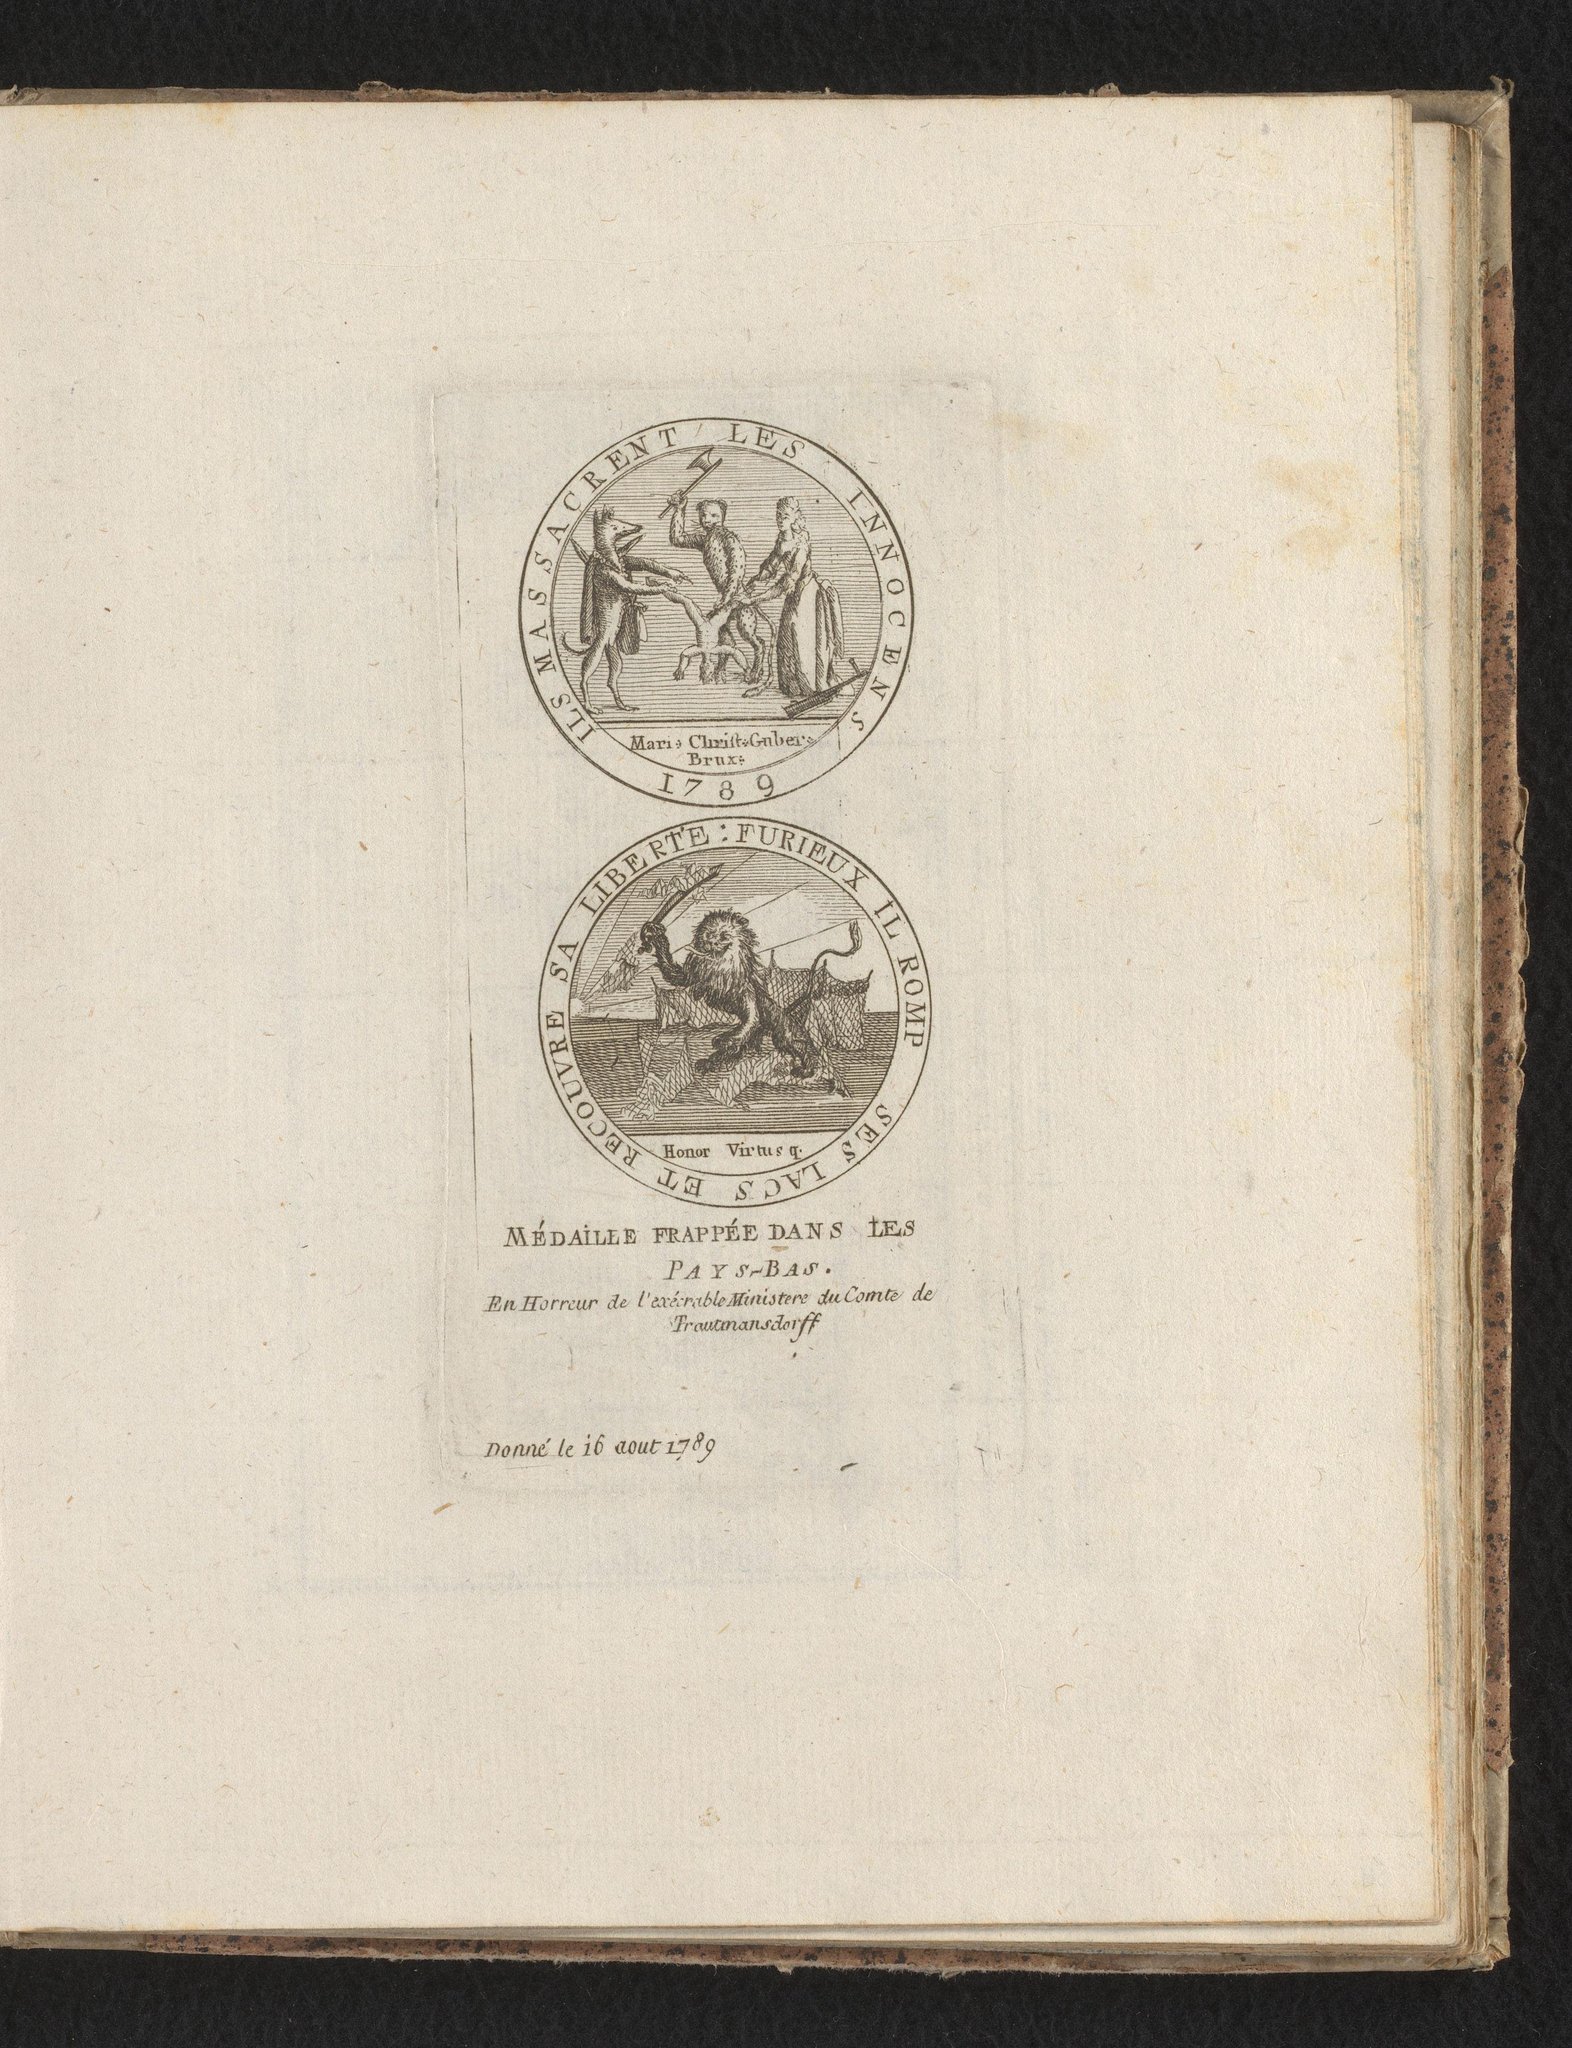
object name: print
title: Médaille frappée dans les Pays-Bas. En Horreur de l'exécrable Ministre du Comte de Strautmansdorf (Trautmansdorff)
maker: Anonymous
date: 1787-1790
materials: paper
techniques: engraving, etching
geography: southern netherlands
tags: vienna, medal (considered as a piece of sculpture, regardless of its specific function), brabant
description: Beide zijden van een penning tegen de wreedheden bedreven in Brabant; met de datum 16 augustus 1789. Op de voorzijde houden een wolf en een vrouw een kind vast dat doormidden wordt gehakt door een luipaard. Op de keerzijde bevrijdt de Brabantse leeuw zich uit een net. In het onderschrift wordt er verwezen naar landvoogd Trauttmansdorff. Onderdeel van de gebundelde verzameling prenten betrekking hebbend op de gebeurtenissen van de Brabantse Omwenteling en de periode 1787-1790.